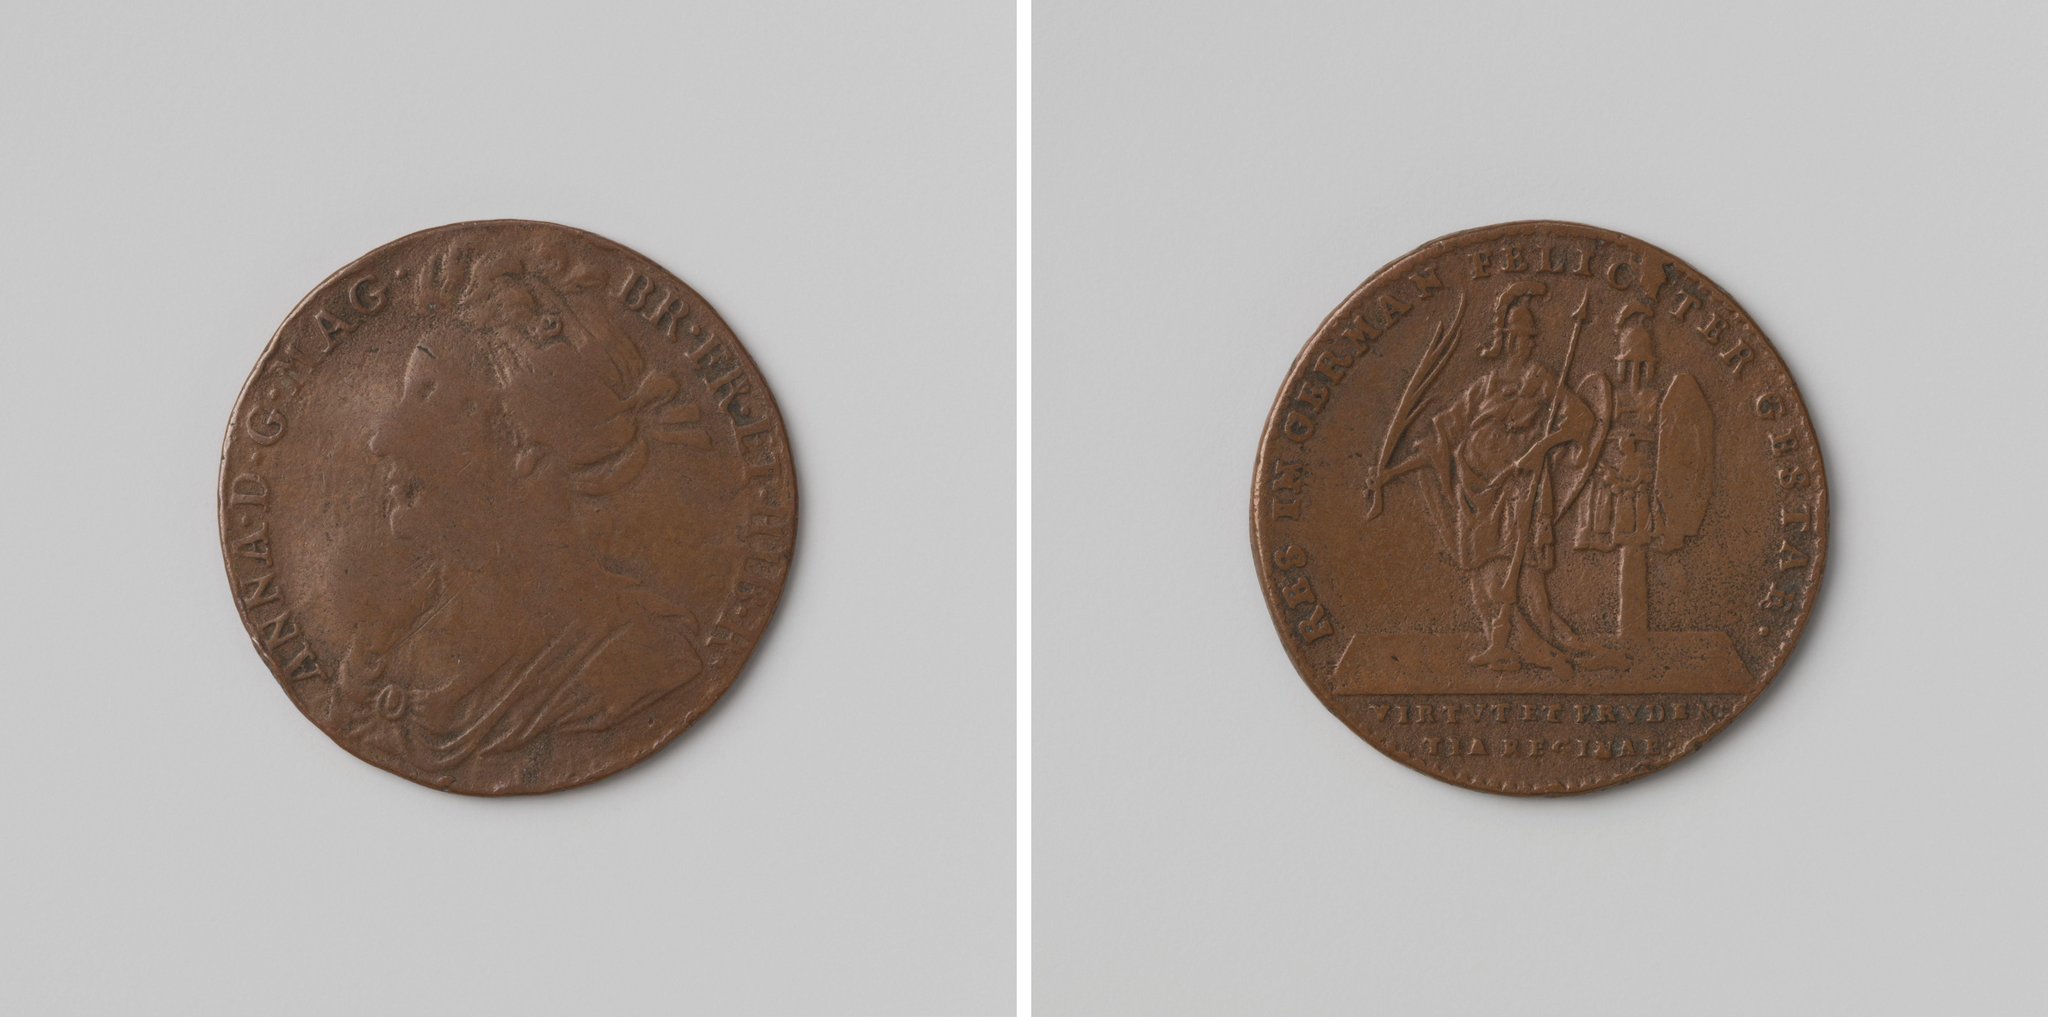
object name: jeton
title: Slag bij Blenheim, rekenpenning geslagen ter ere van Anna Stuart, koningin van Engeland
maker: johann gottlieb lauffer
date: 1704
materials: copper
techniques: striking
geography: nuremberg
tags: london, anna stuart (koningin van engeland en schotland)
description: Koperen penning. Voorzijde: borststuk vrouw binnen omschrift. Keerzijde: gehelmde Minerva met schild, speer en palmtak, staande naast wapentrophee binnen omschrift; afsnede: opschrift